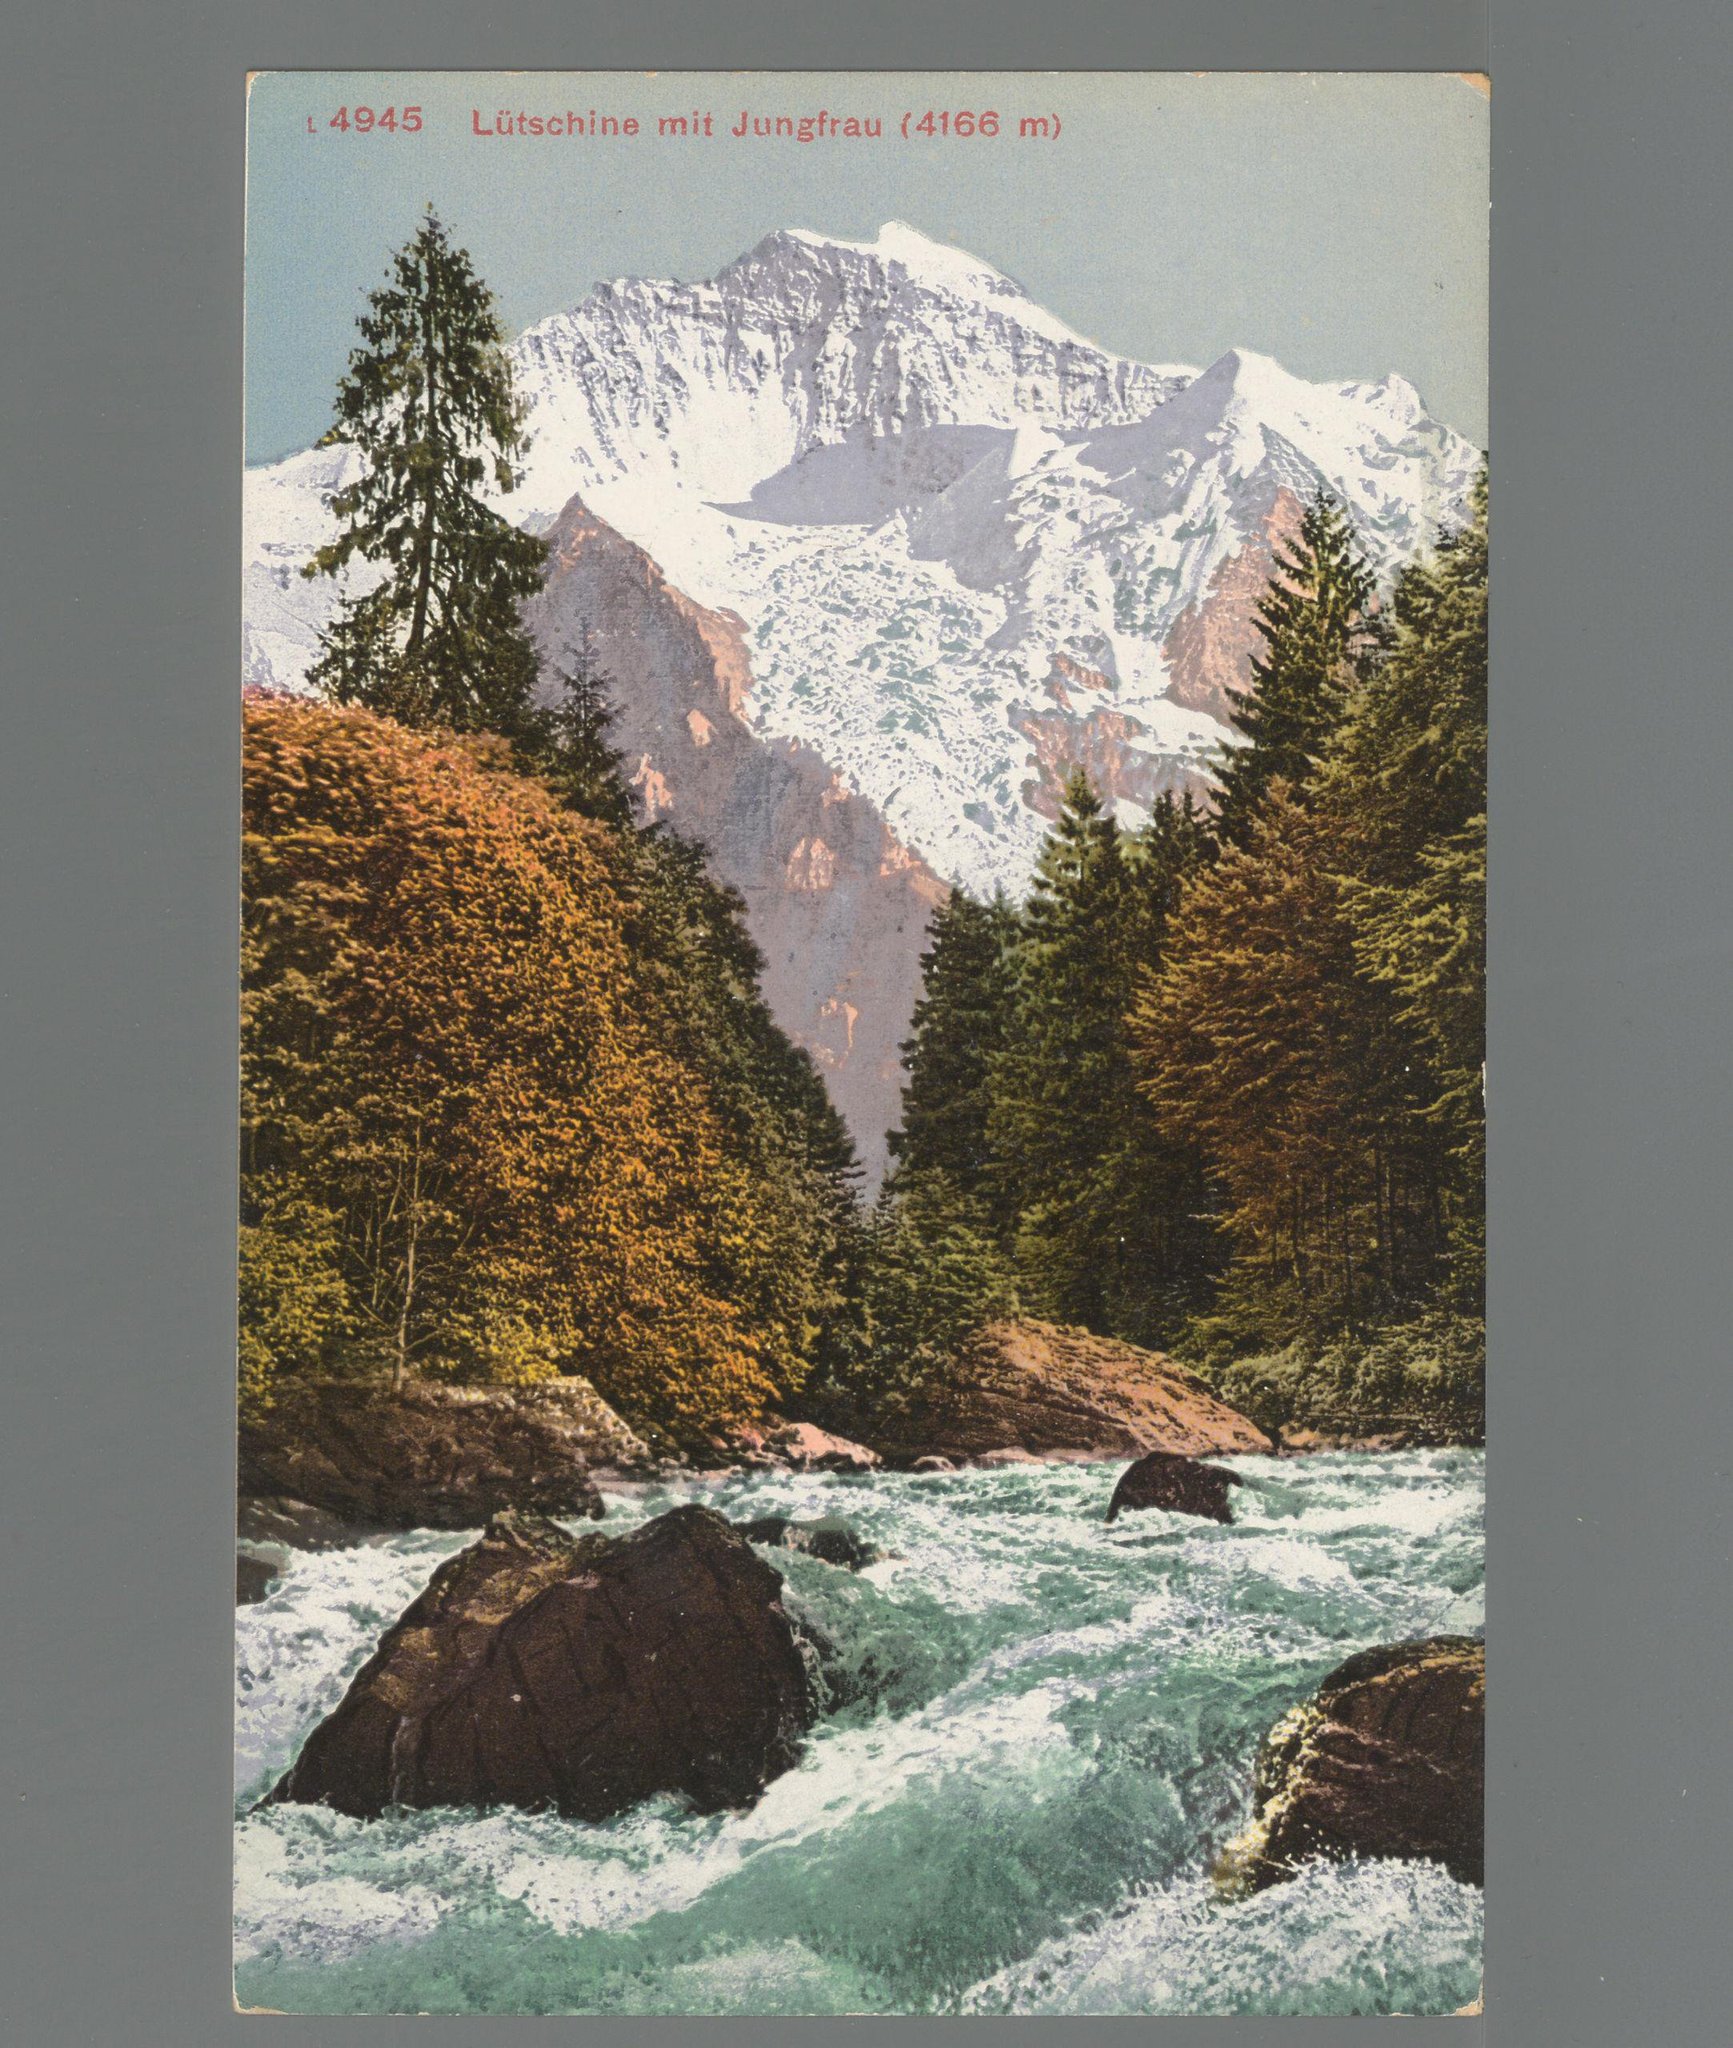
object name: ansichtkaart, prentbriefkaart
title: Lütschine mit Jungfrau (4166 m)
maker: Anonymous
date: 1905-1920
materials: cardboard, photographic process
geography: berner alpen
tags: river, mountain-range, snow peaks